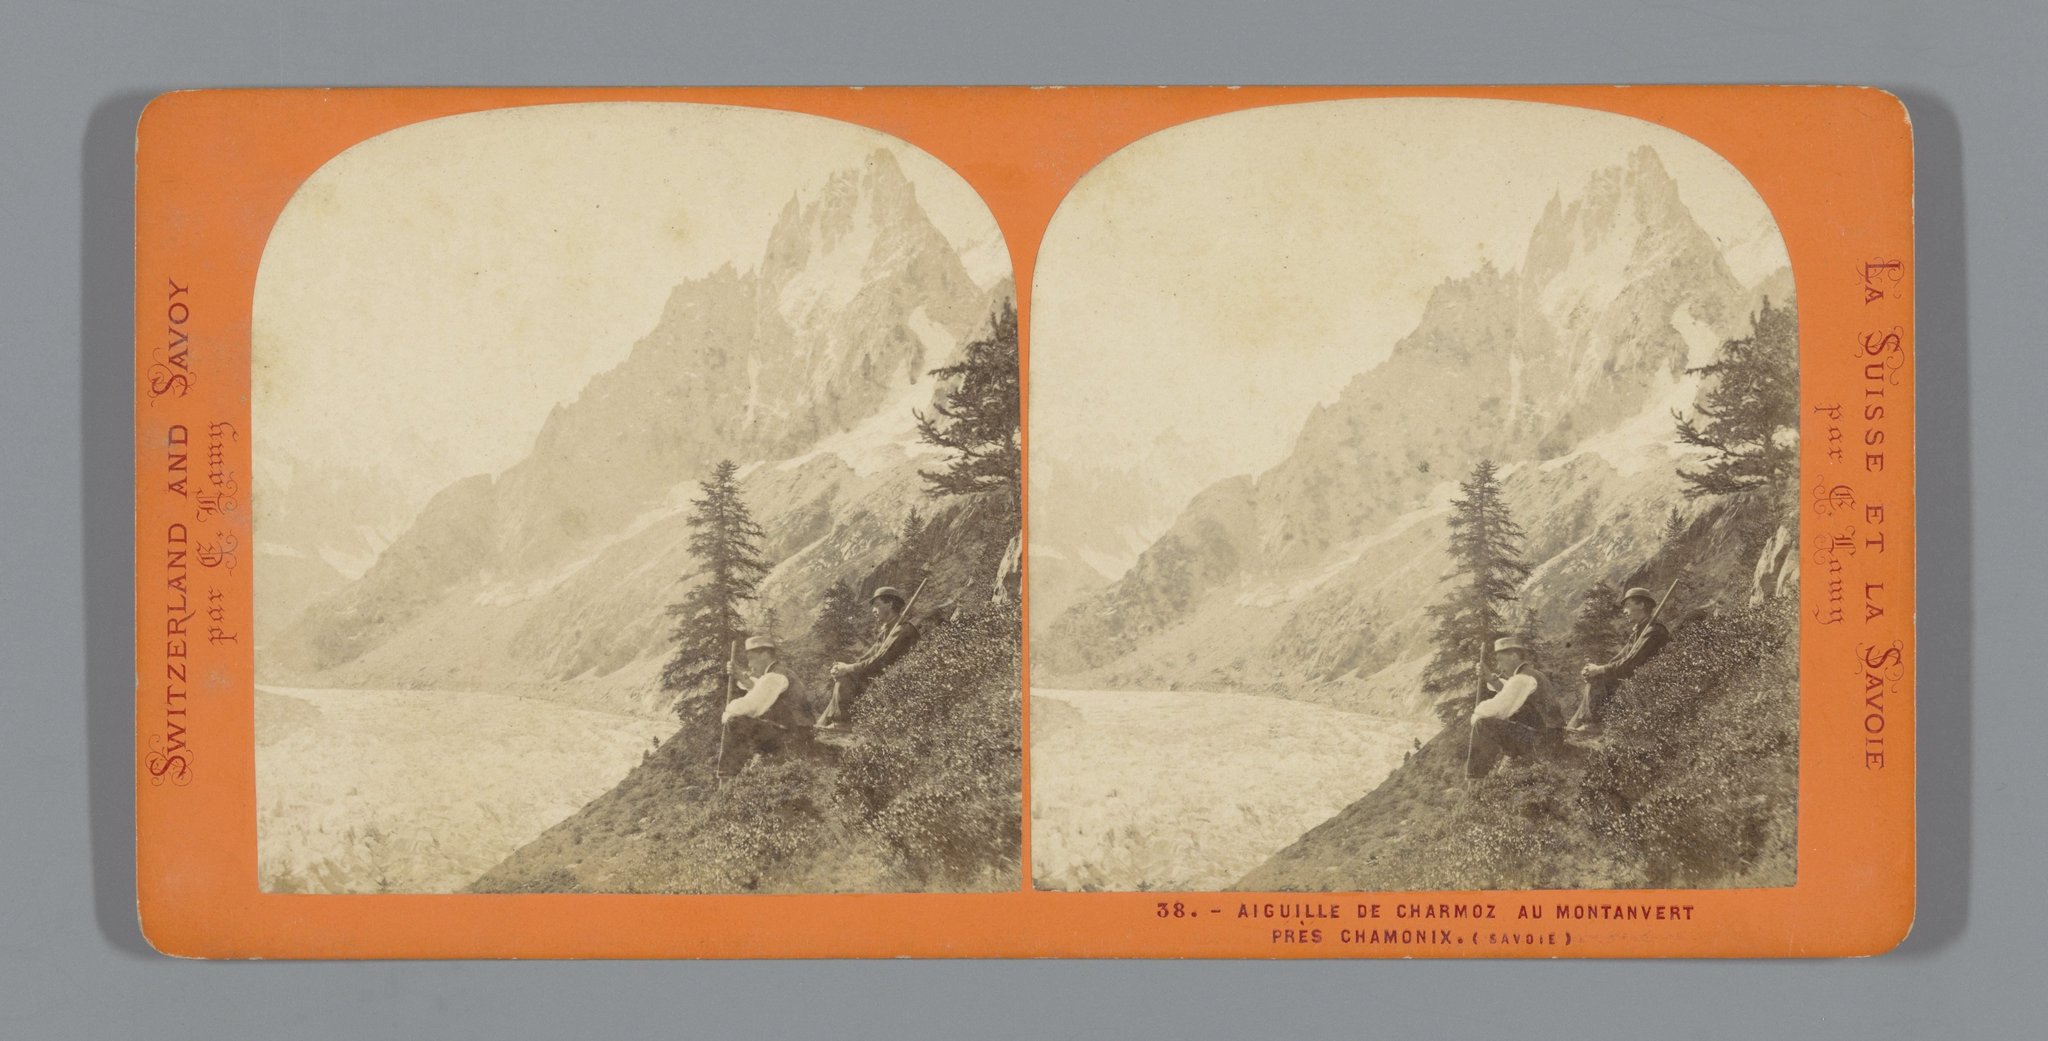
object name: stereograph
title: Gezicht op de Aiguille des Grands Charmoz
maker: ernest eléonor pierre lamy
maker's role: publisher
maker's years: 1828-1900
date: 1860-1880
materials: cardboard, photographic support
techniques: albumen print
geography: savoie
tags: mountain-top, peak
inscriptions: number: ‘38.’